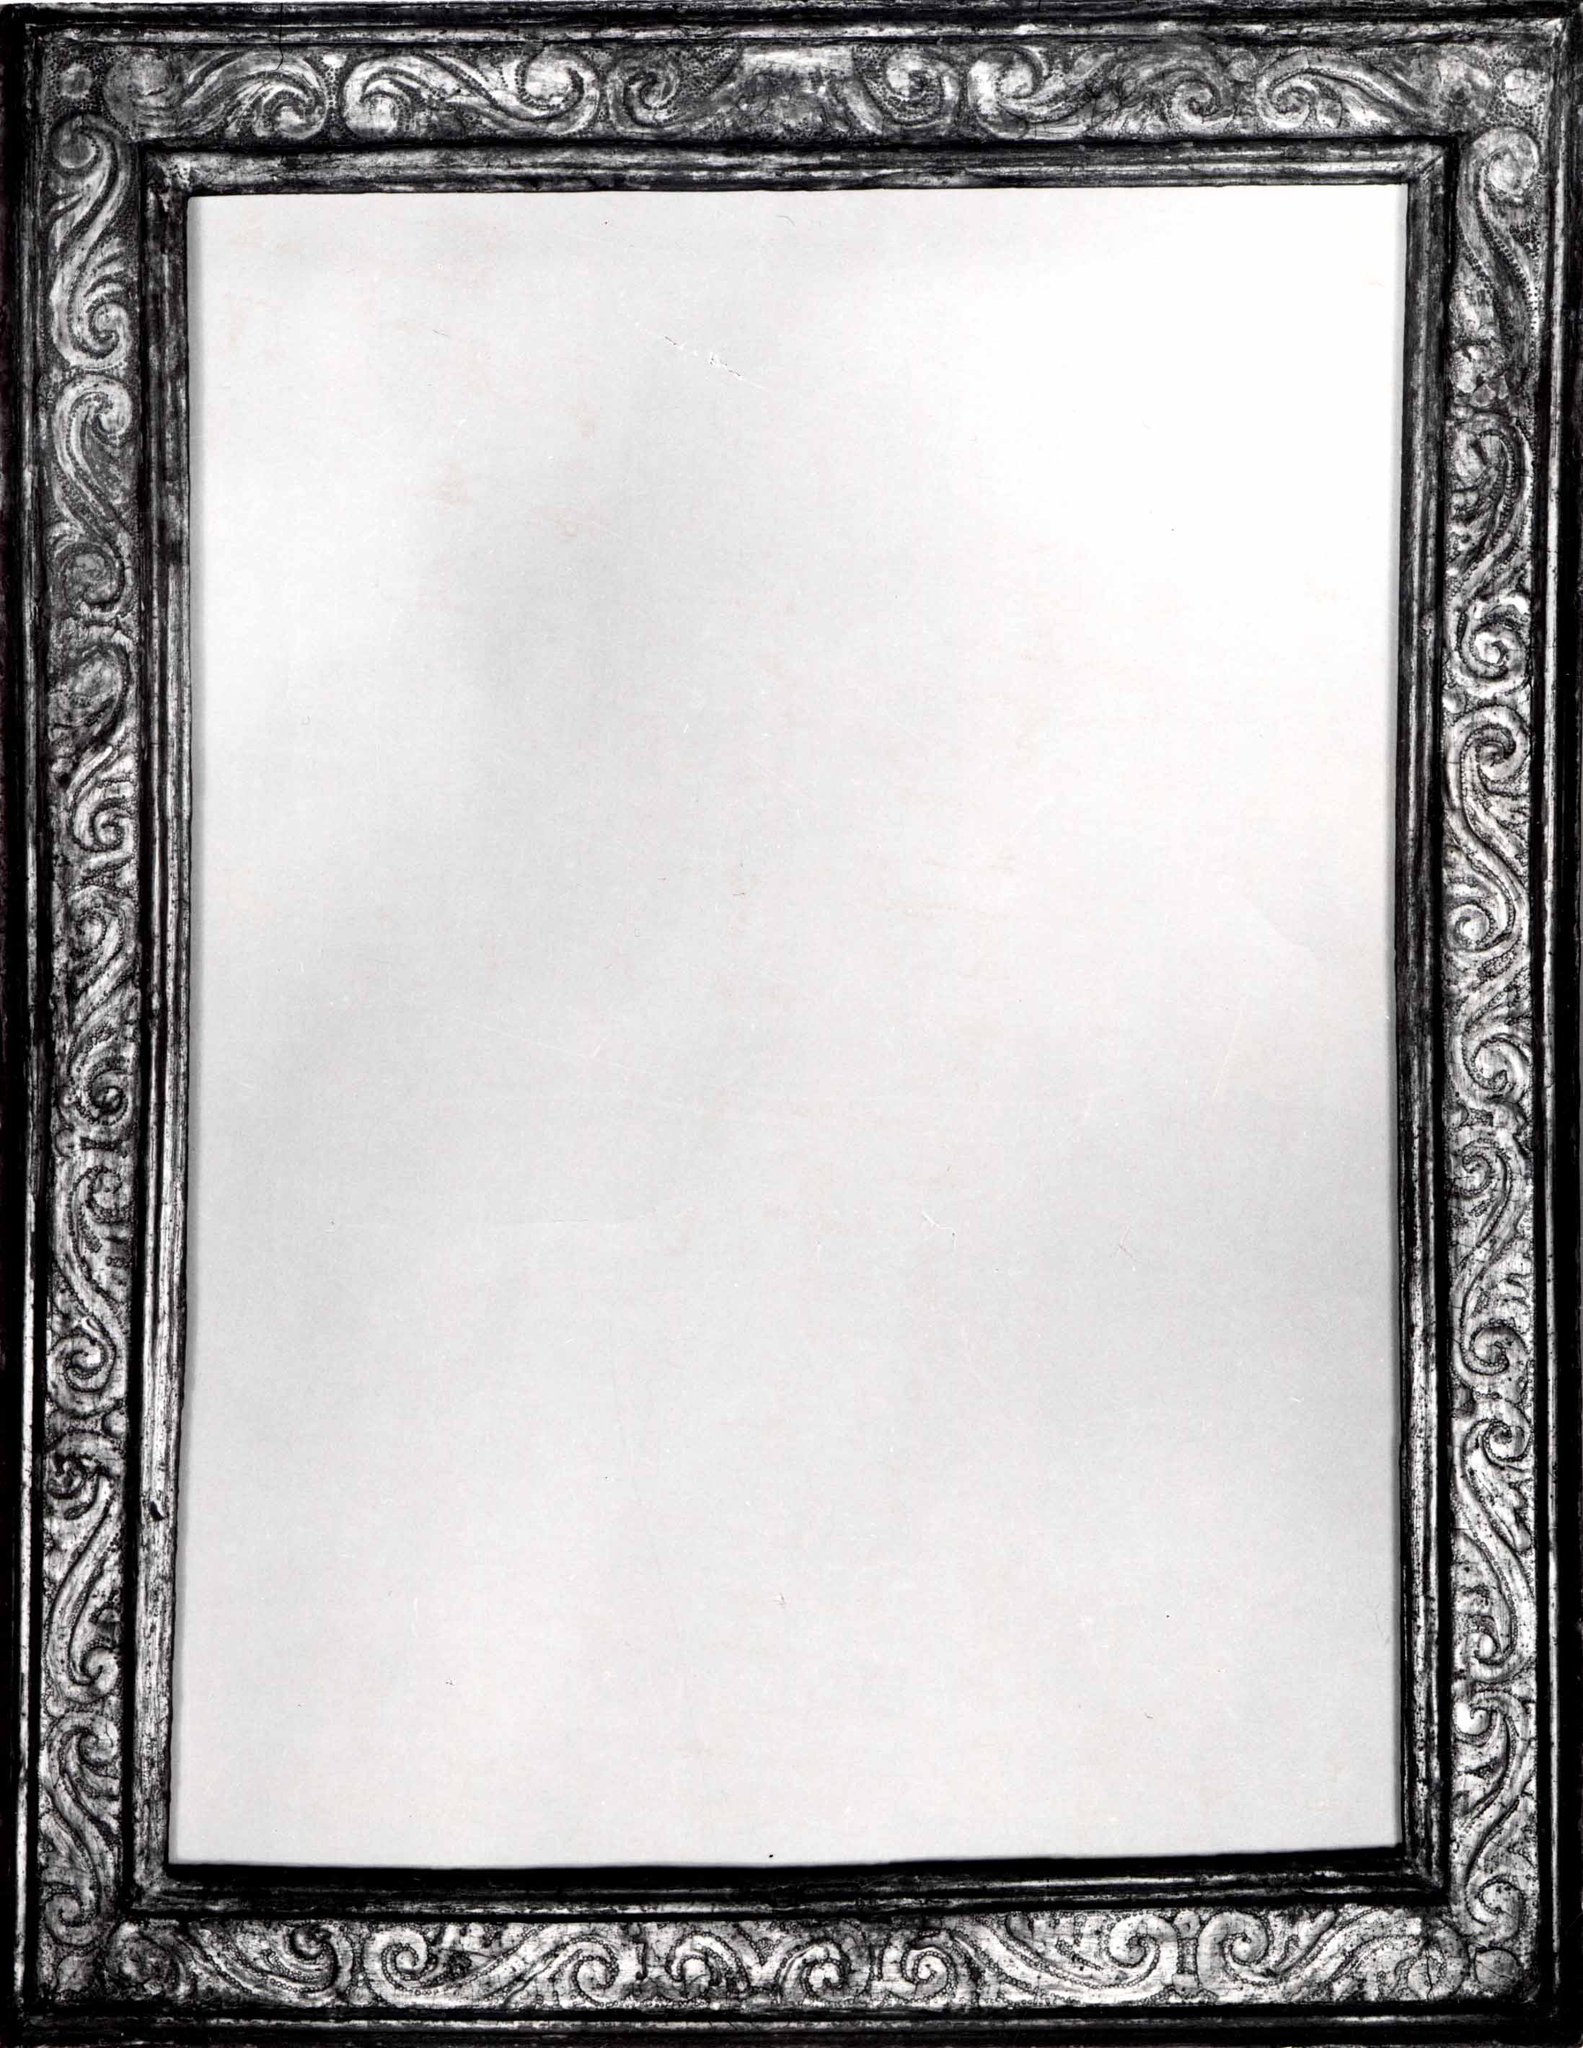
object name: frame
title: Cassetta frame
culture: lombard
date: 1601-1633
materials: gilt